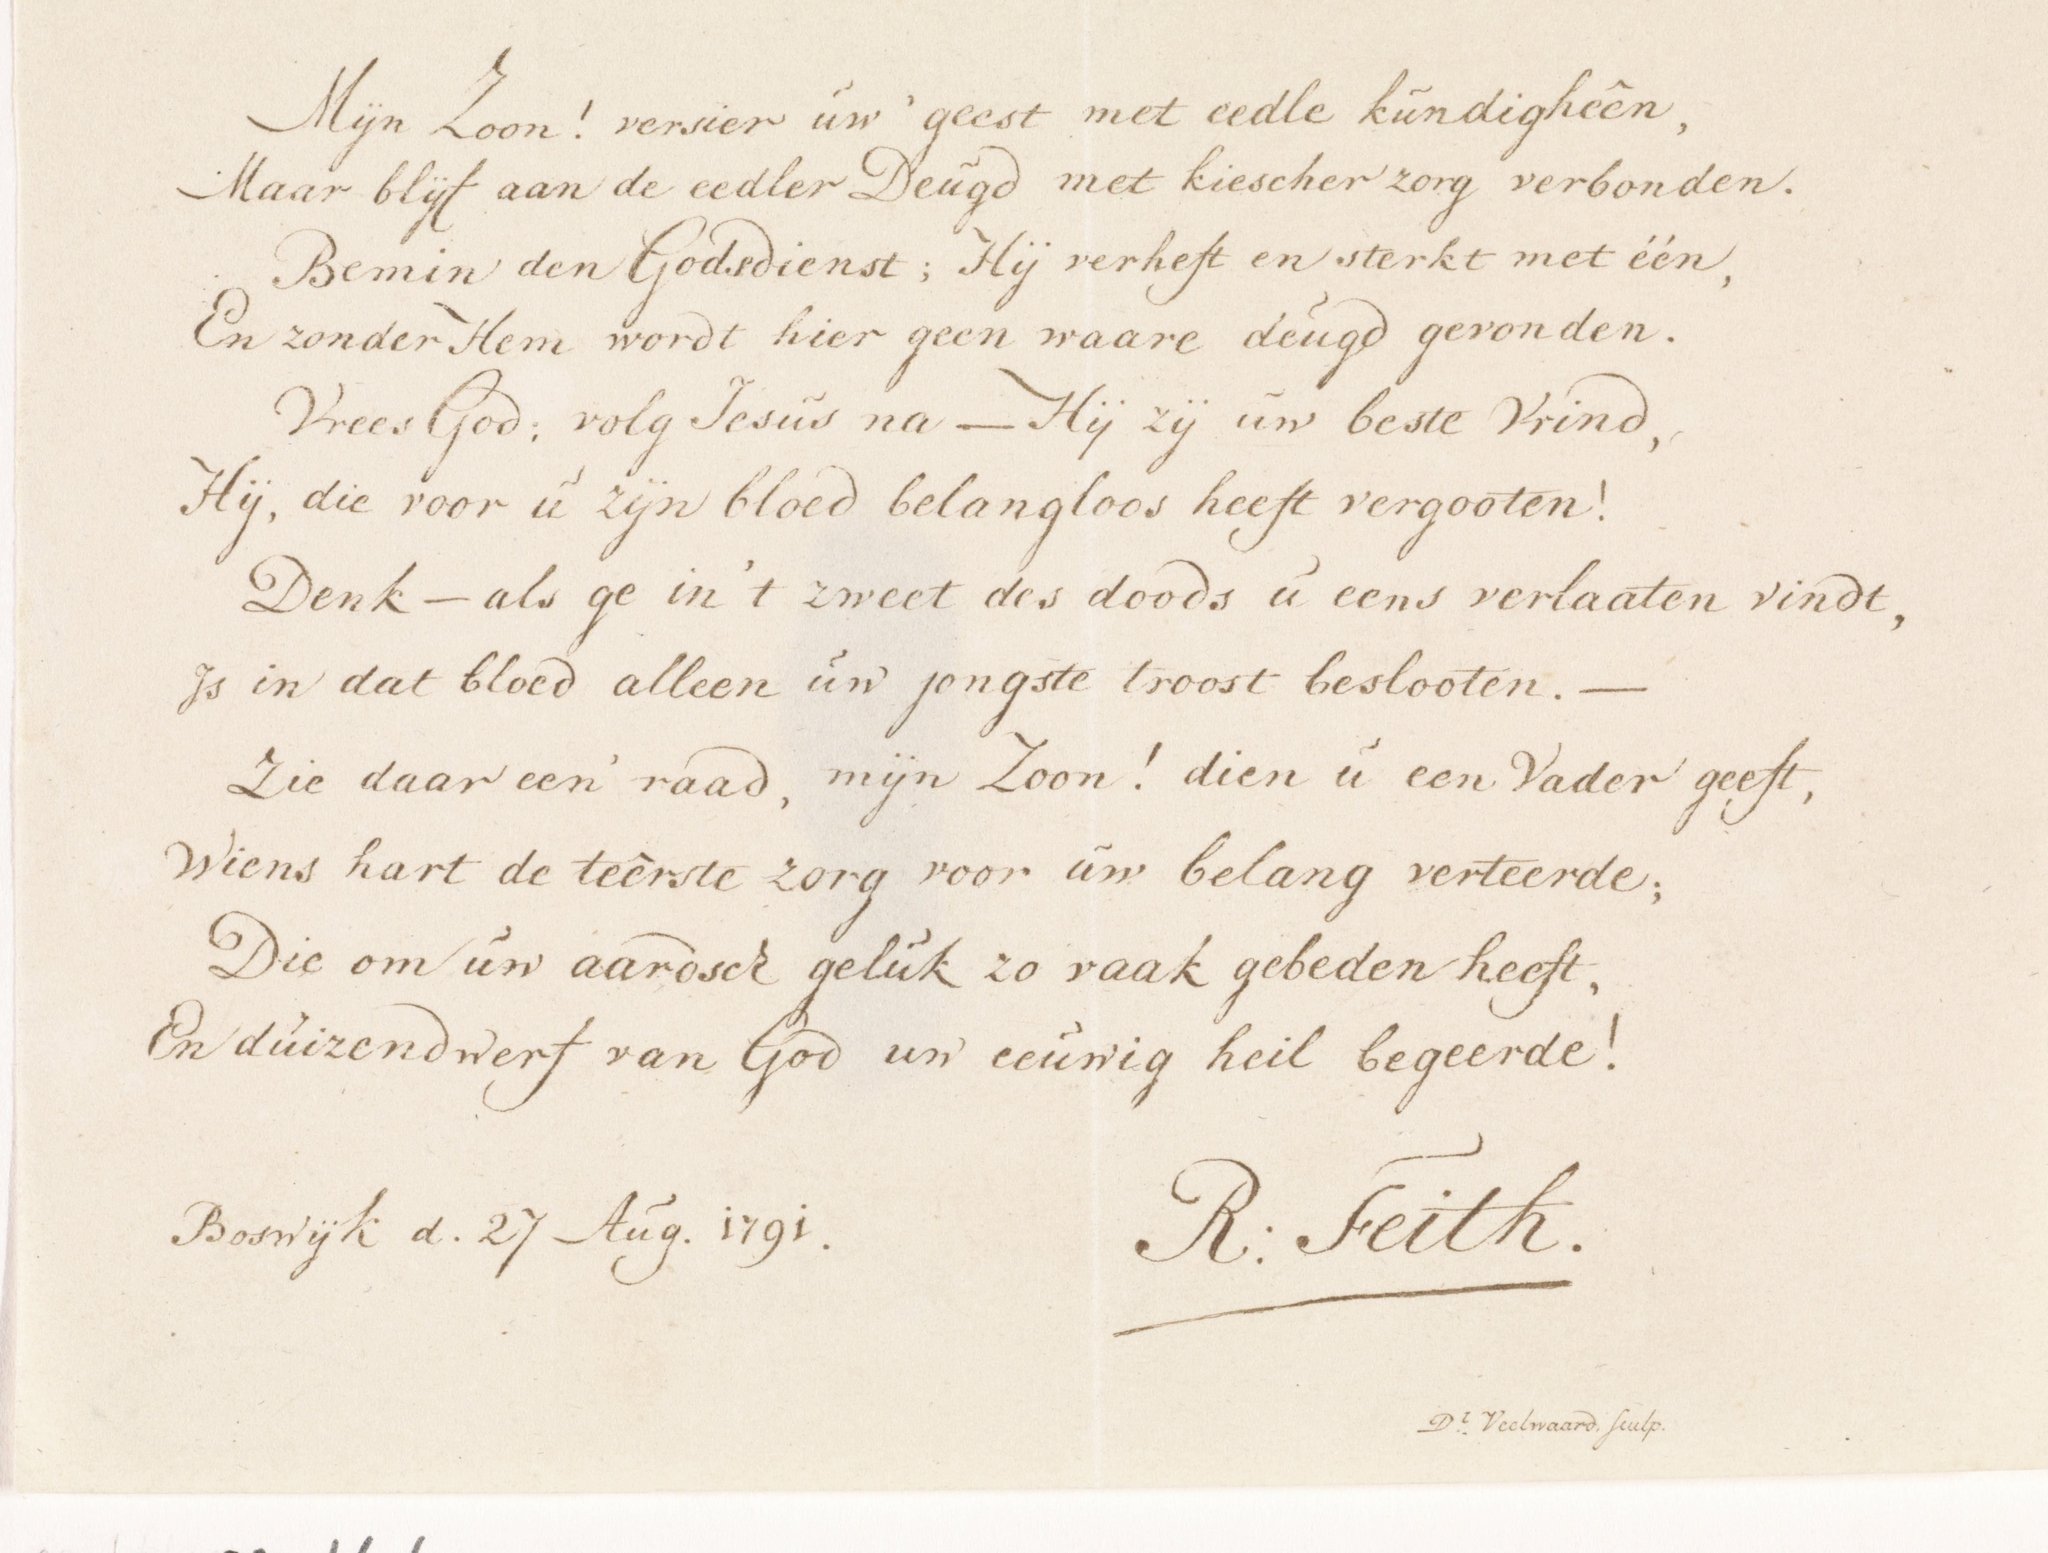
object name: print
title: Brief van Rhijnvis Feith B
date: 1791-1851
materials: paper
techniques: etching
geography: amsterdam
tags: rhijnvis feith, handwriting, written text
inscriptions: collector's mark: Lugt 2228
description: Reproductie van een twaalfregelige brief van Rijnvis Feith aan zijn zoon.